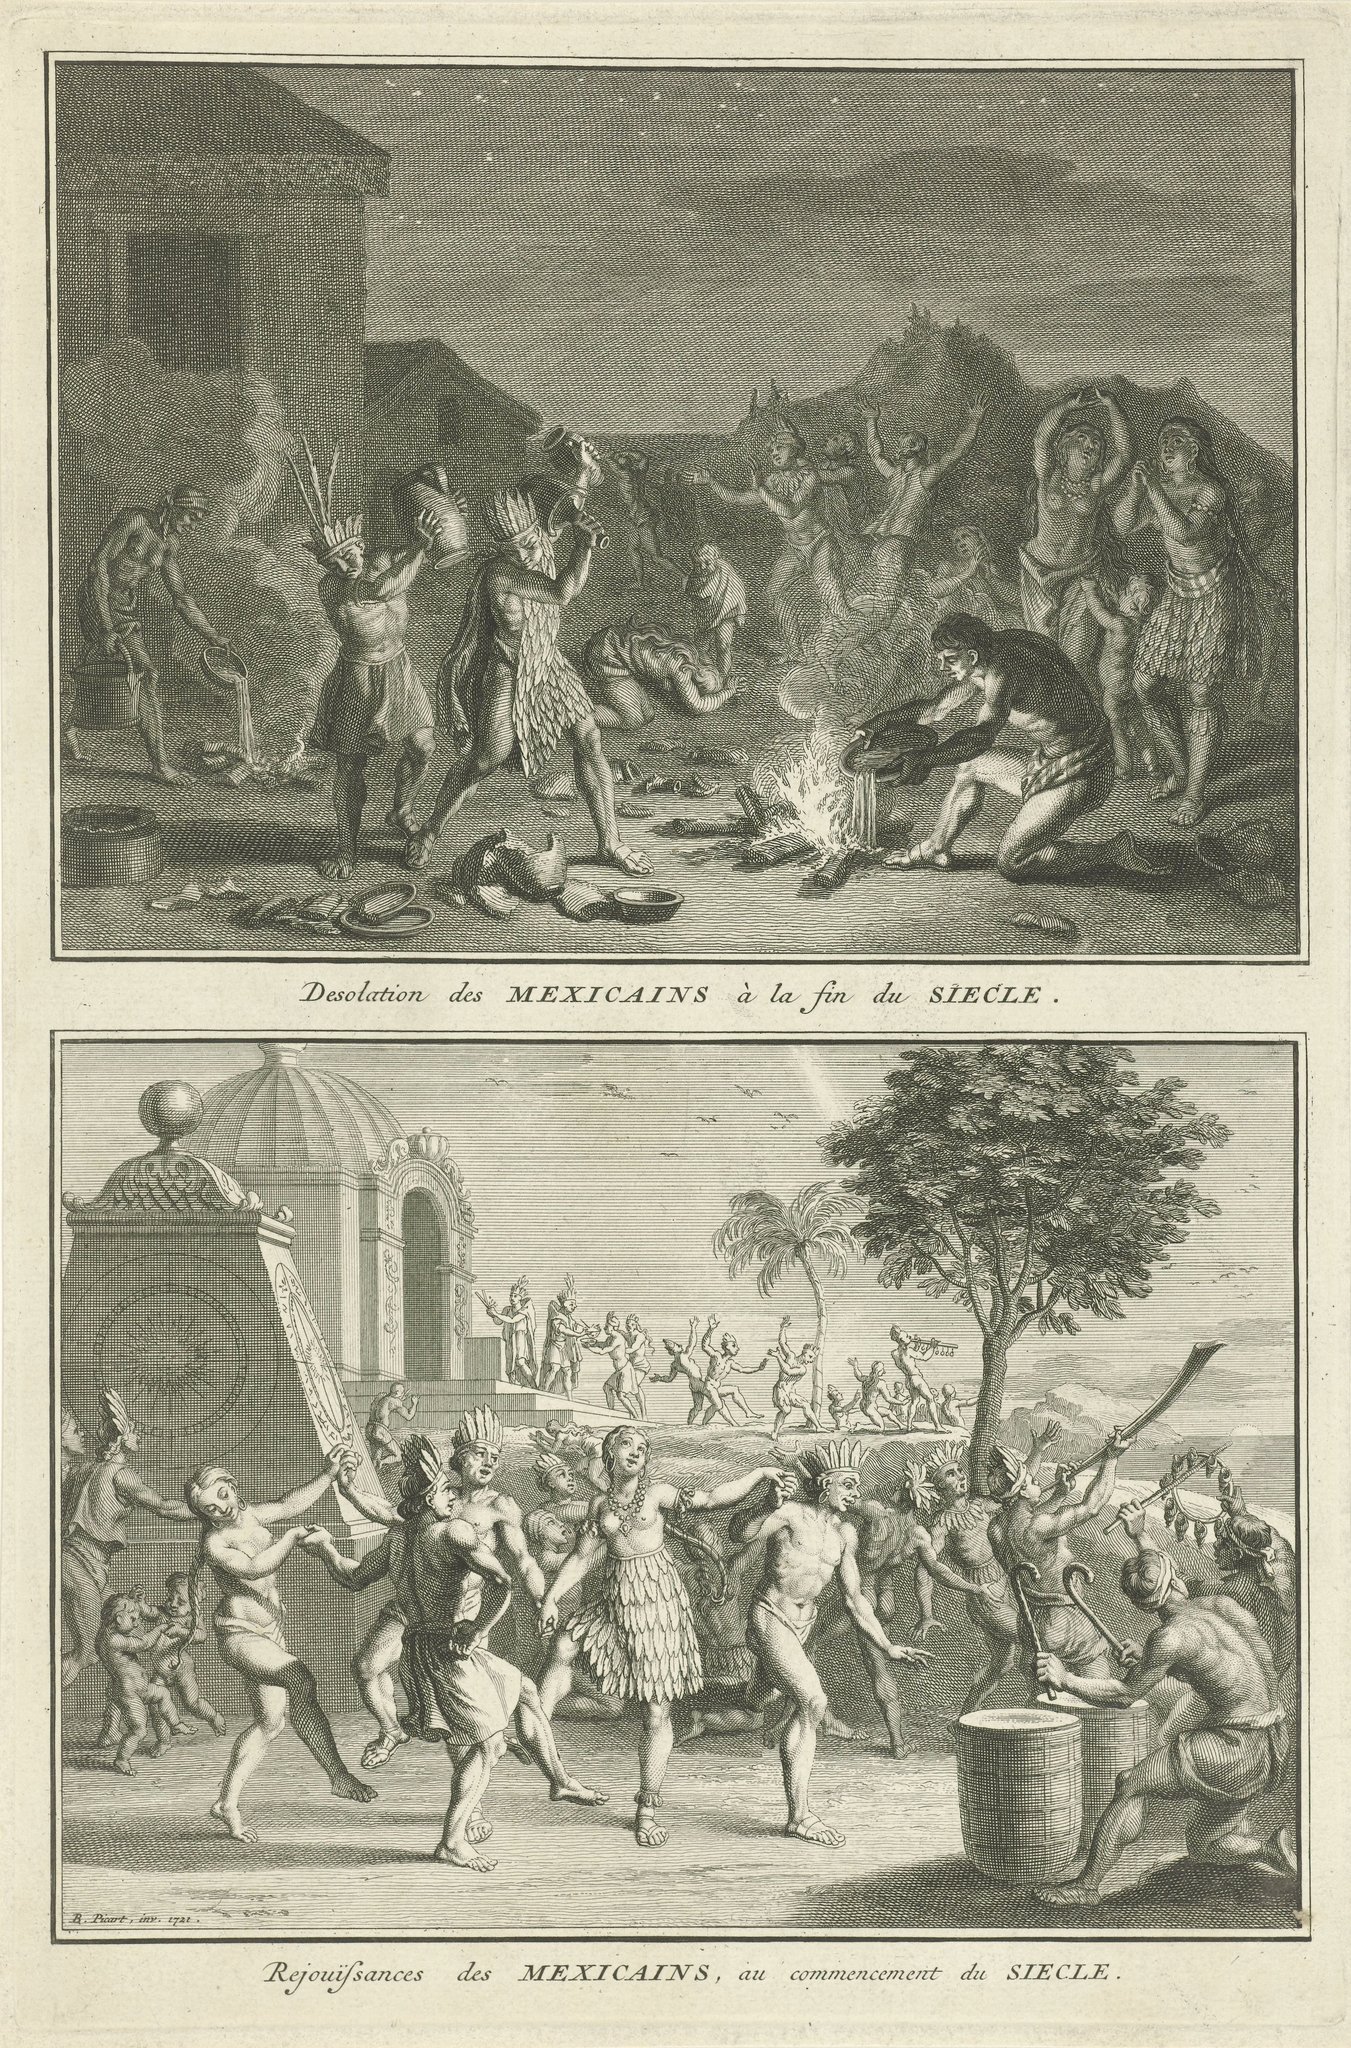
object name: book illustration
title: Rituelen van oorspronkelijke bewoners van Mexico rond de eeuwwisseling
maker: bernard picart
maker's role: draughtsman, print maker, publisher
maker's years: 1673-1733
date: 1721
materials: paper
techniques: engraving, etching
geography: amsterdam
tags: ritual practices ~ american indian religions, temple, shrine ~ american indian religions, indigenous peoples of central america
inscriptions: collector's mark: Lugt 2228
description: Prent ook gebruikt in: Picart, Bernard. Naaukeurige beschryving der uitwendige godtsdienst-plichten, kerk-zeden en gewoontens van alle volkeren der waereldt, deel IÍI. [Vertaald in het Nederlands door] Moubach, Abraham. Den Haag, Amsterdam, Rotterdam: Rutgert Alberts, Hermannus Uytwerf, Jan Daniel Beman, Isaac van der Kloot, 1727-1738.